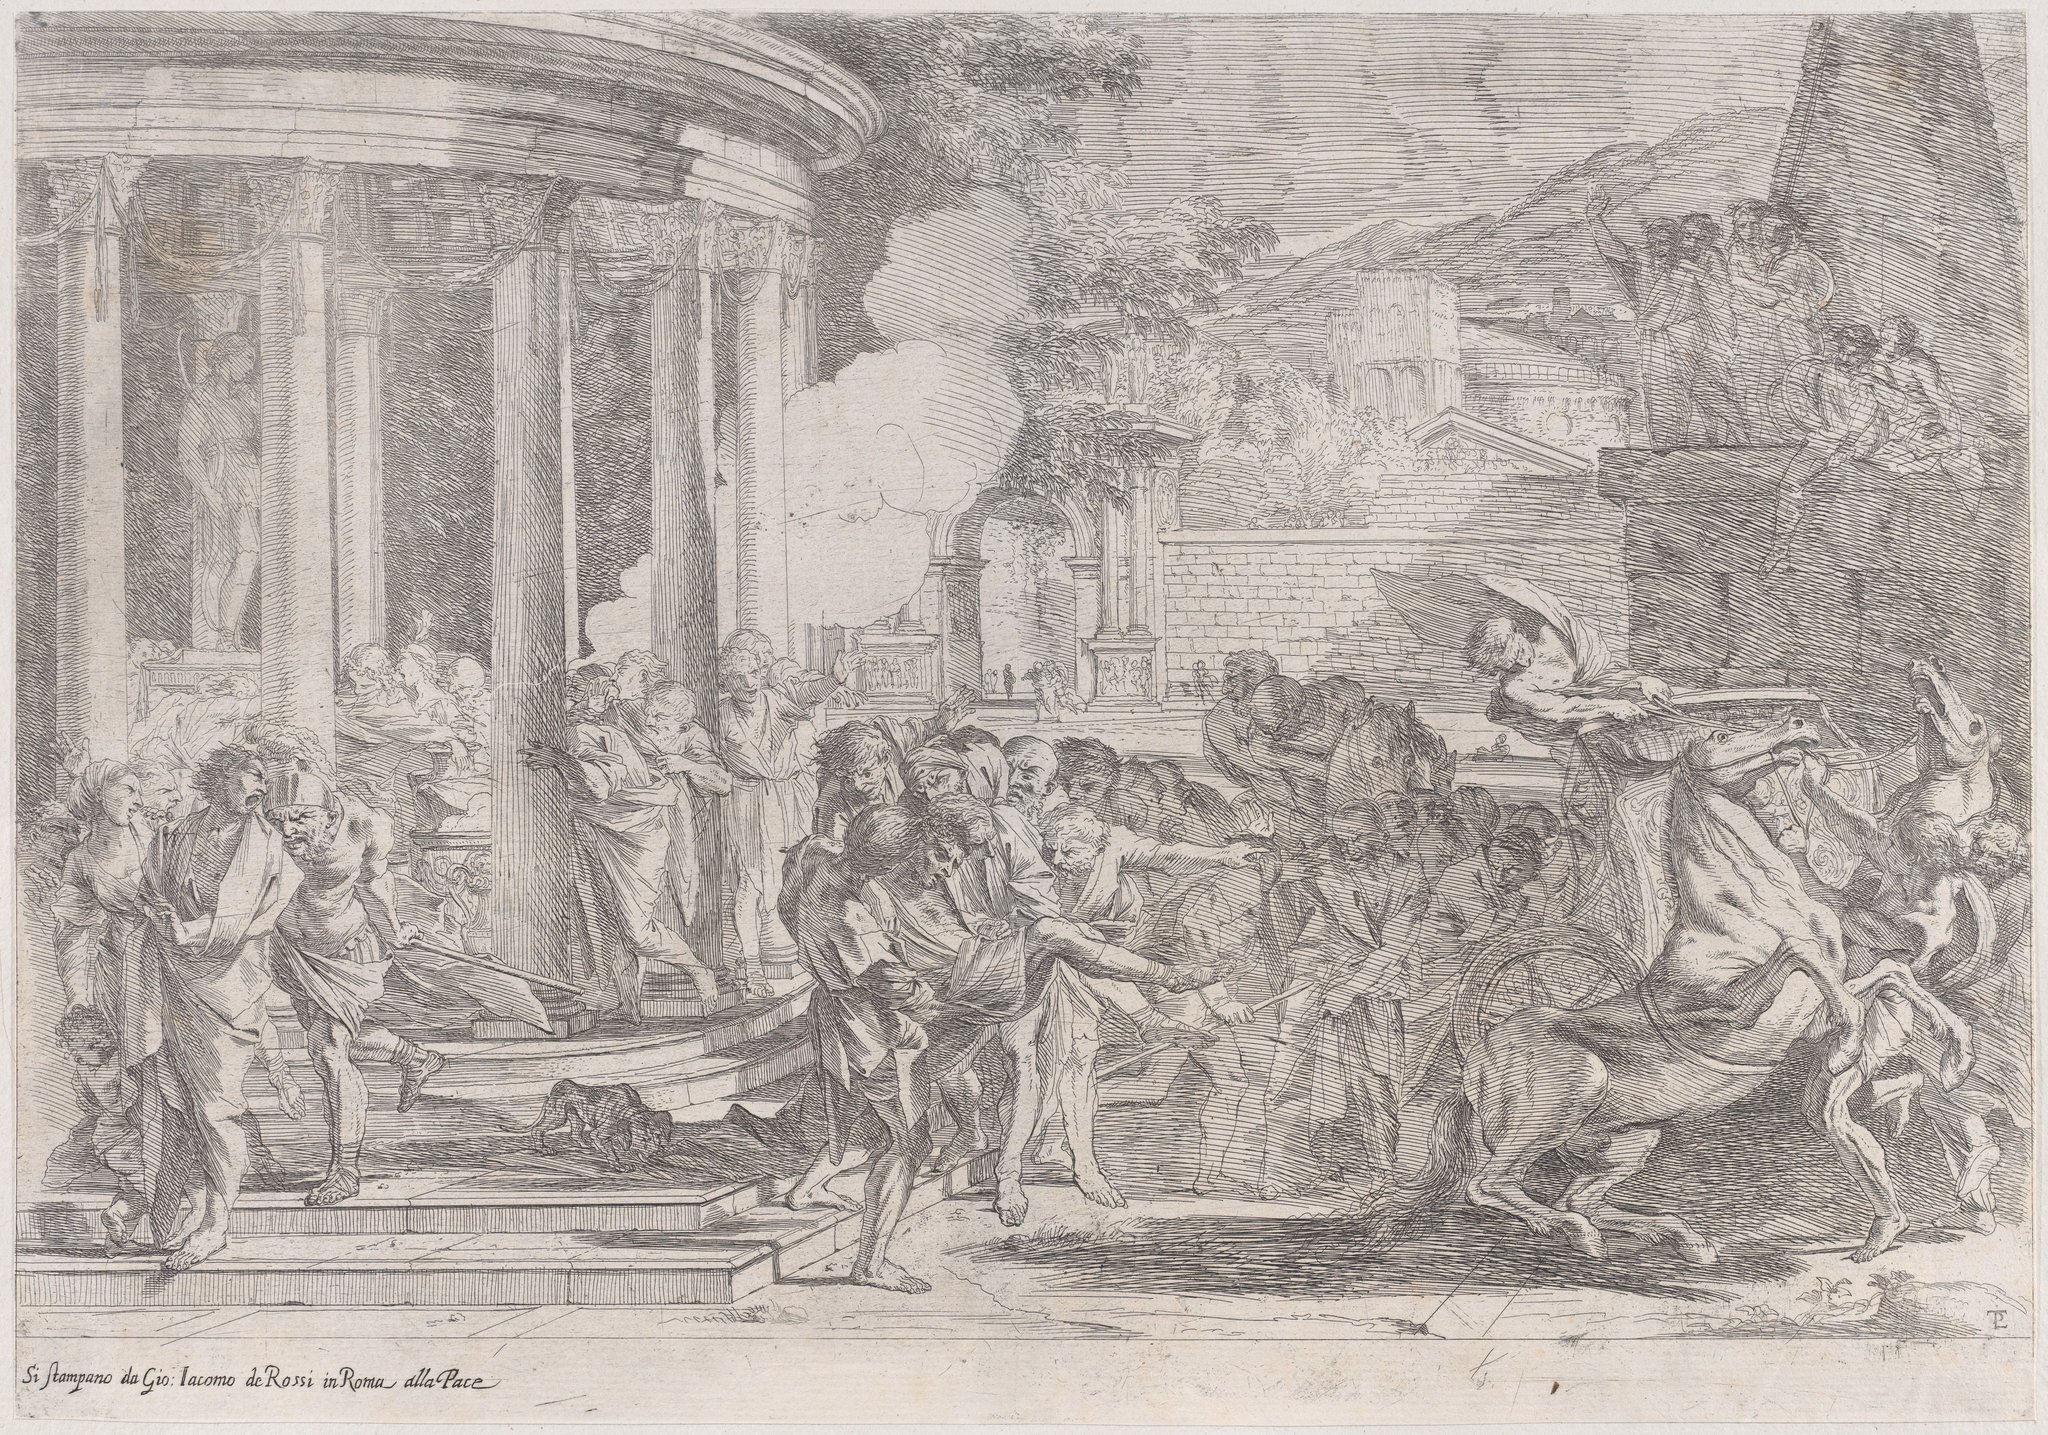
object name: print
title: Sinorix carried from the temple of Artemis trying to escape the effects of the poisoning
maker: pietro testa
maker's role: artist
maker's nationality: italian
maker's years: 1612-1650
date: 1640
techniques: etching